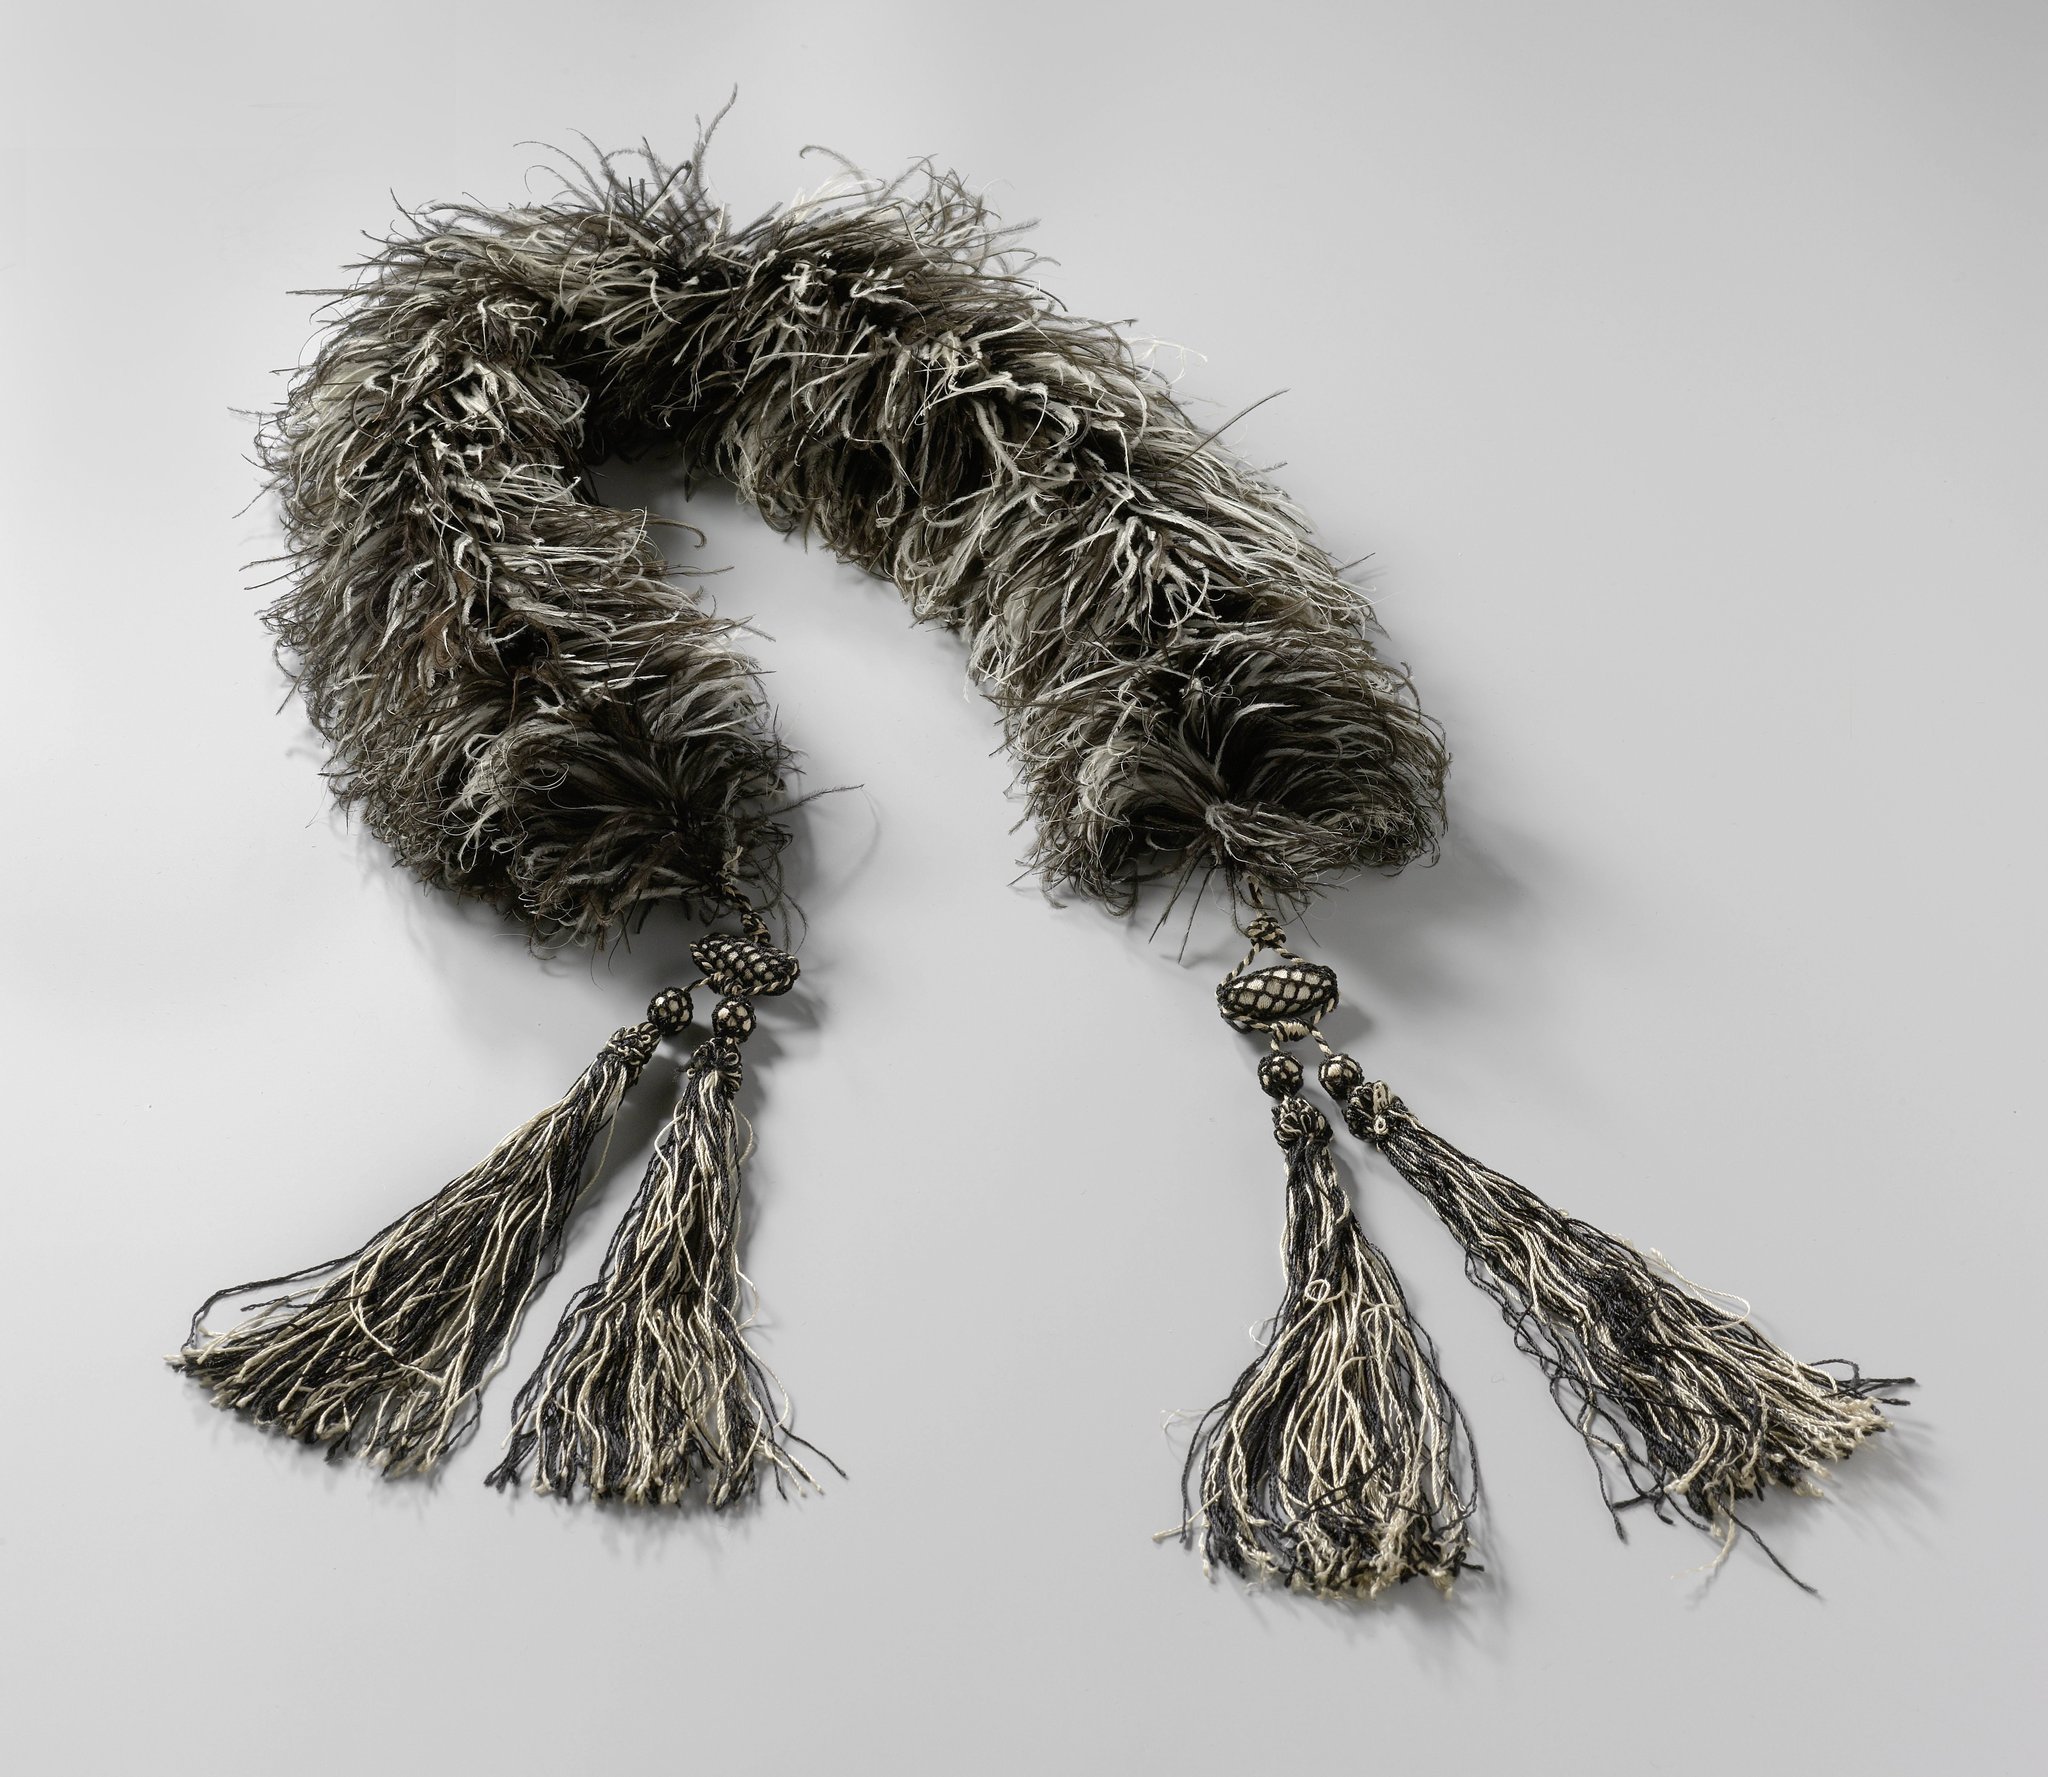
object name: clothing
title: Boa van witte en bruinzwarte struisveren met aan de uiteinden witte en zwarte zijden kwasten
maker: Anonymous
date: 1916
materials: silk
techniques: knotting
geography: paris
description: Boa van gemeleerd witte en bruinzwarte struisveren. Aan beide einden afgewerkt met zijden kwasten in wit en zwart.